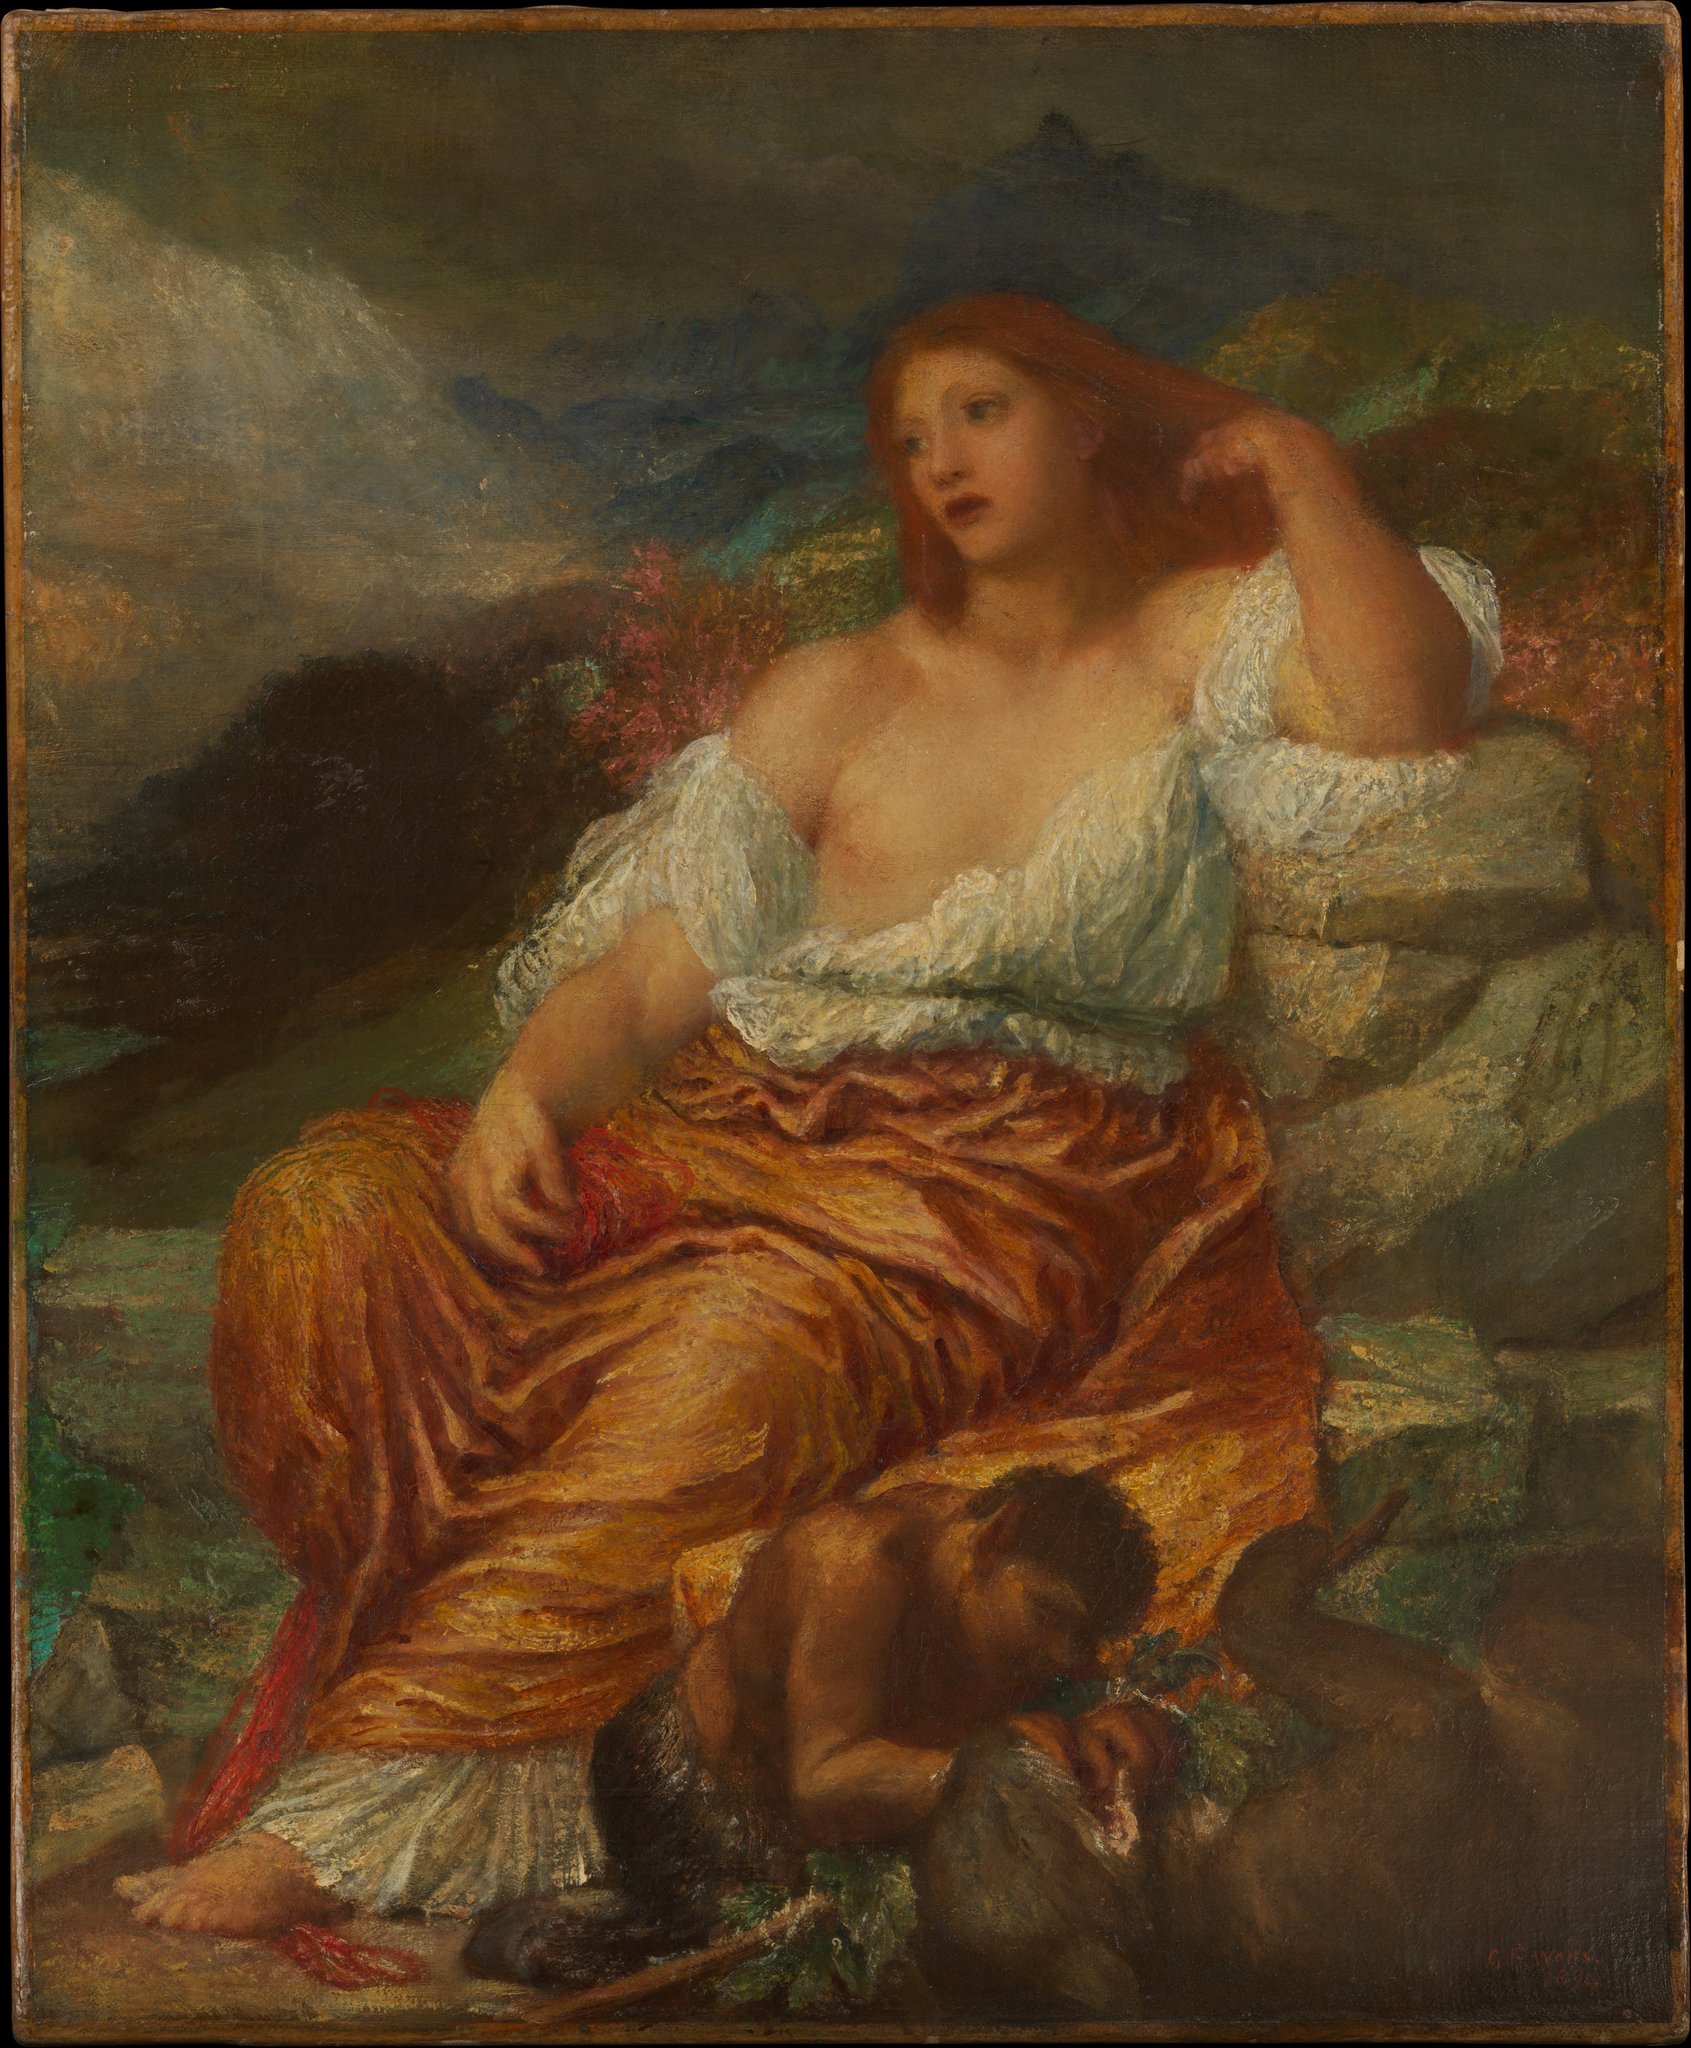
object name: painting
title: Ariadne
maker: george frederic watts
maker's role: artist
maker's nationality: british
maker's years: 1817-1904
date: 1894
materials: canvas, oil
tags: animals,ariadne,satyrs,panthers